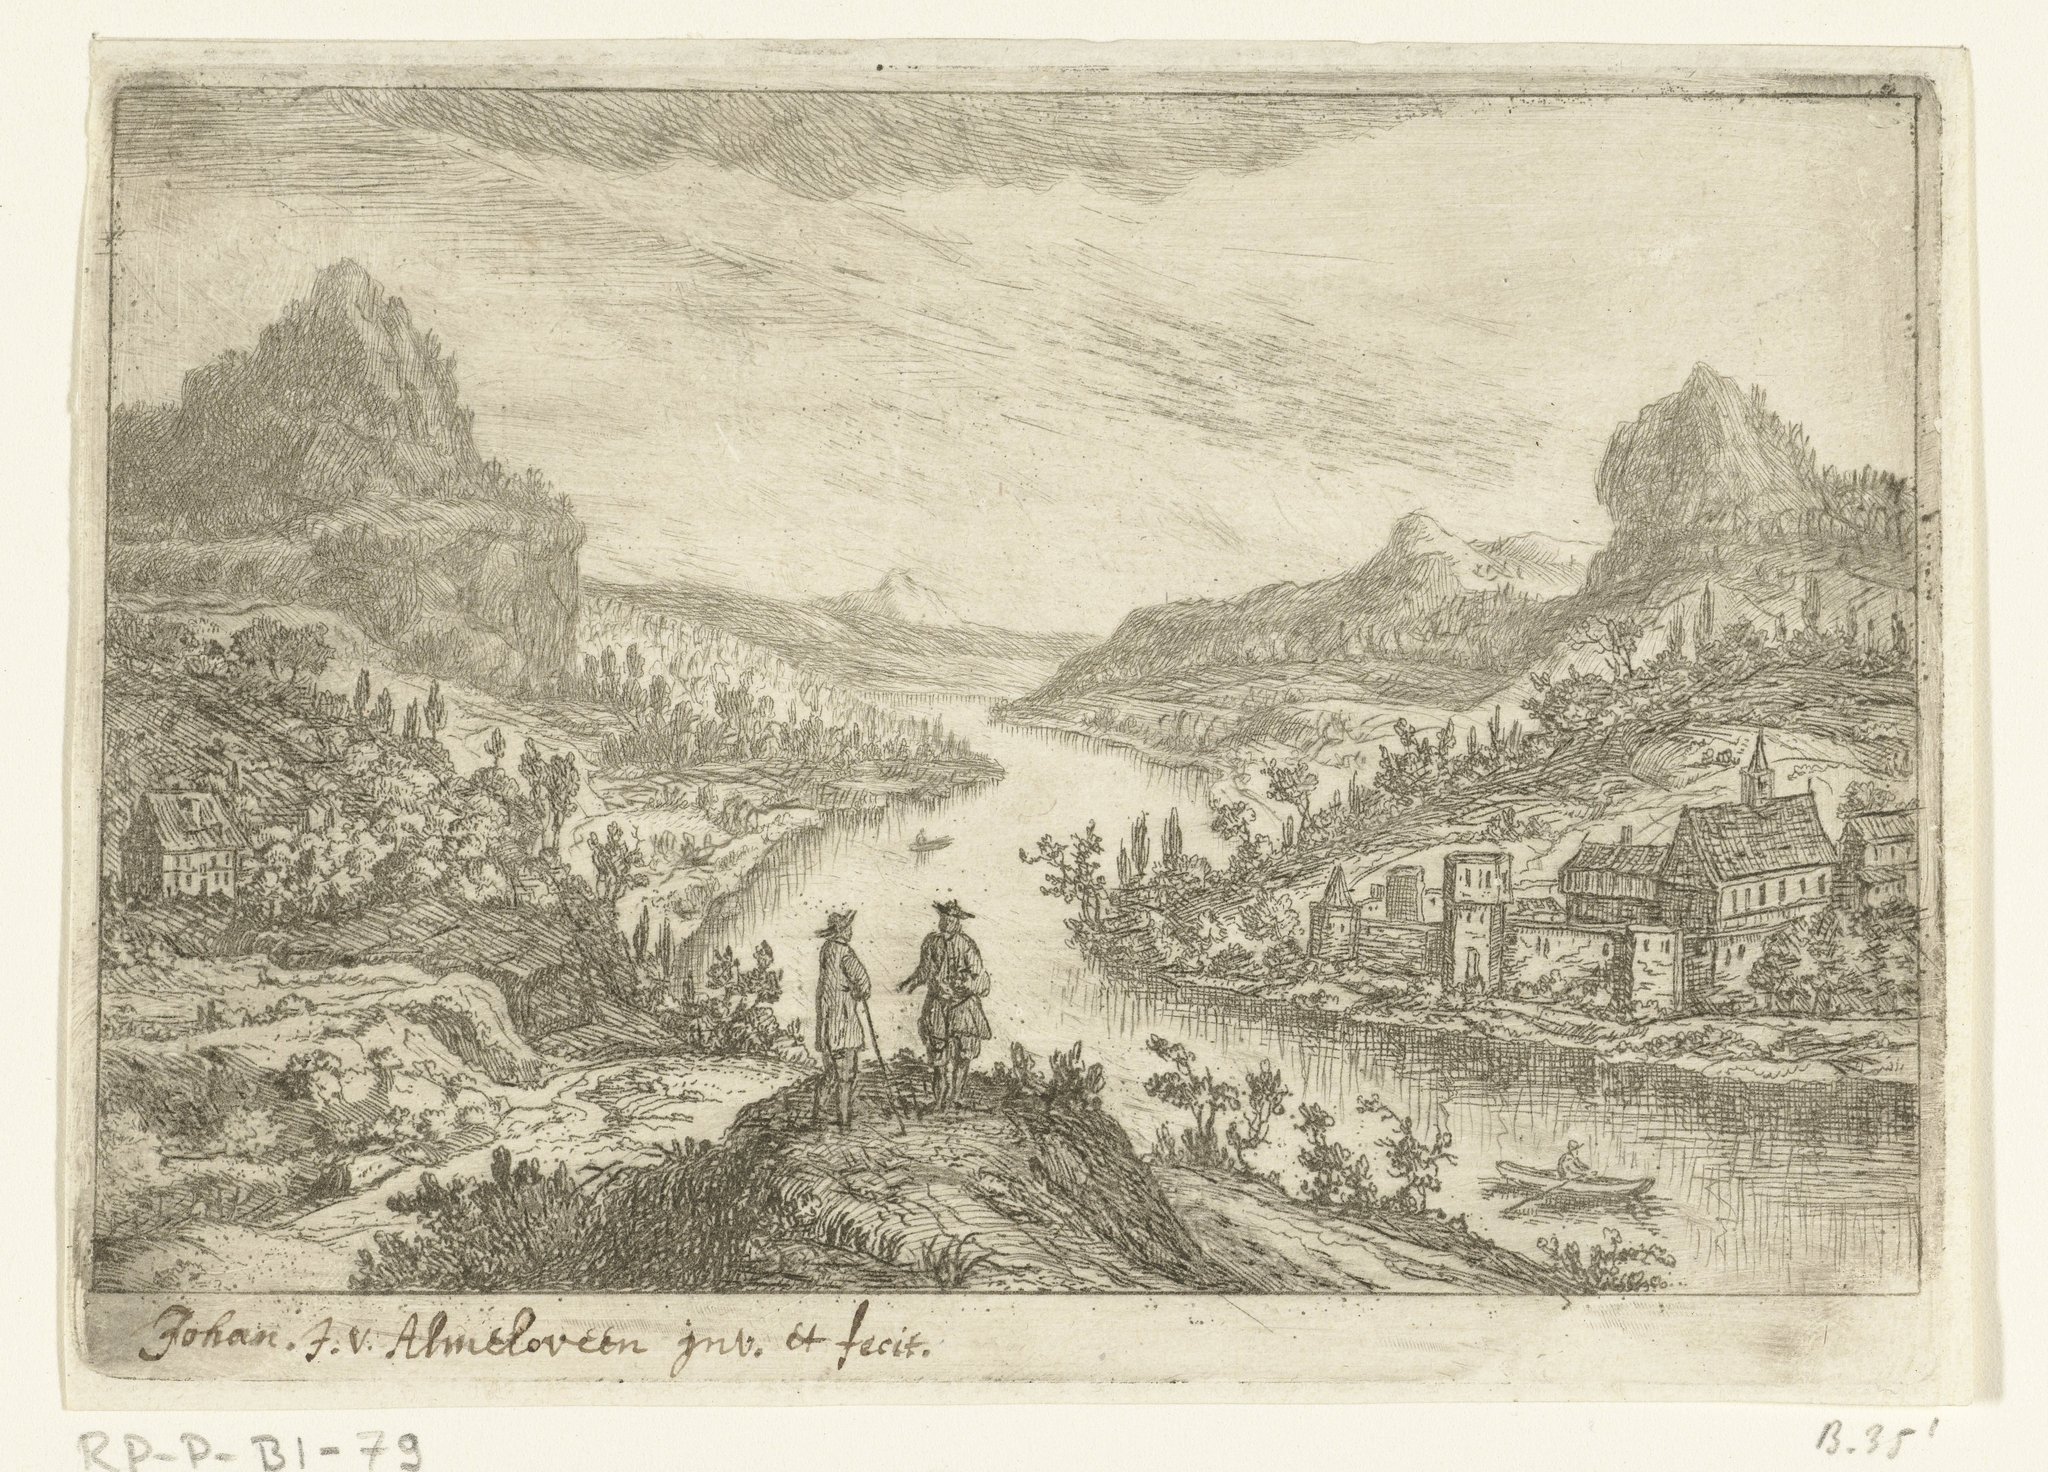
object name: print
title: Vier rivierlandschappen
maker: jan van almeloveen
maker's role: draughtsman, print maker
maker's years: 1652-1683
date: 1662-1683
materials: paper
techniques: etching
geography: netherlands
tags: river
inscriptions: collector's mark: Lugt 240